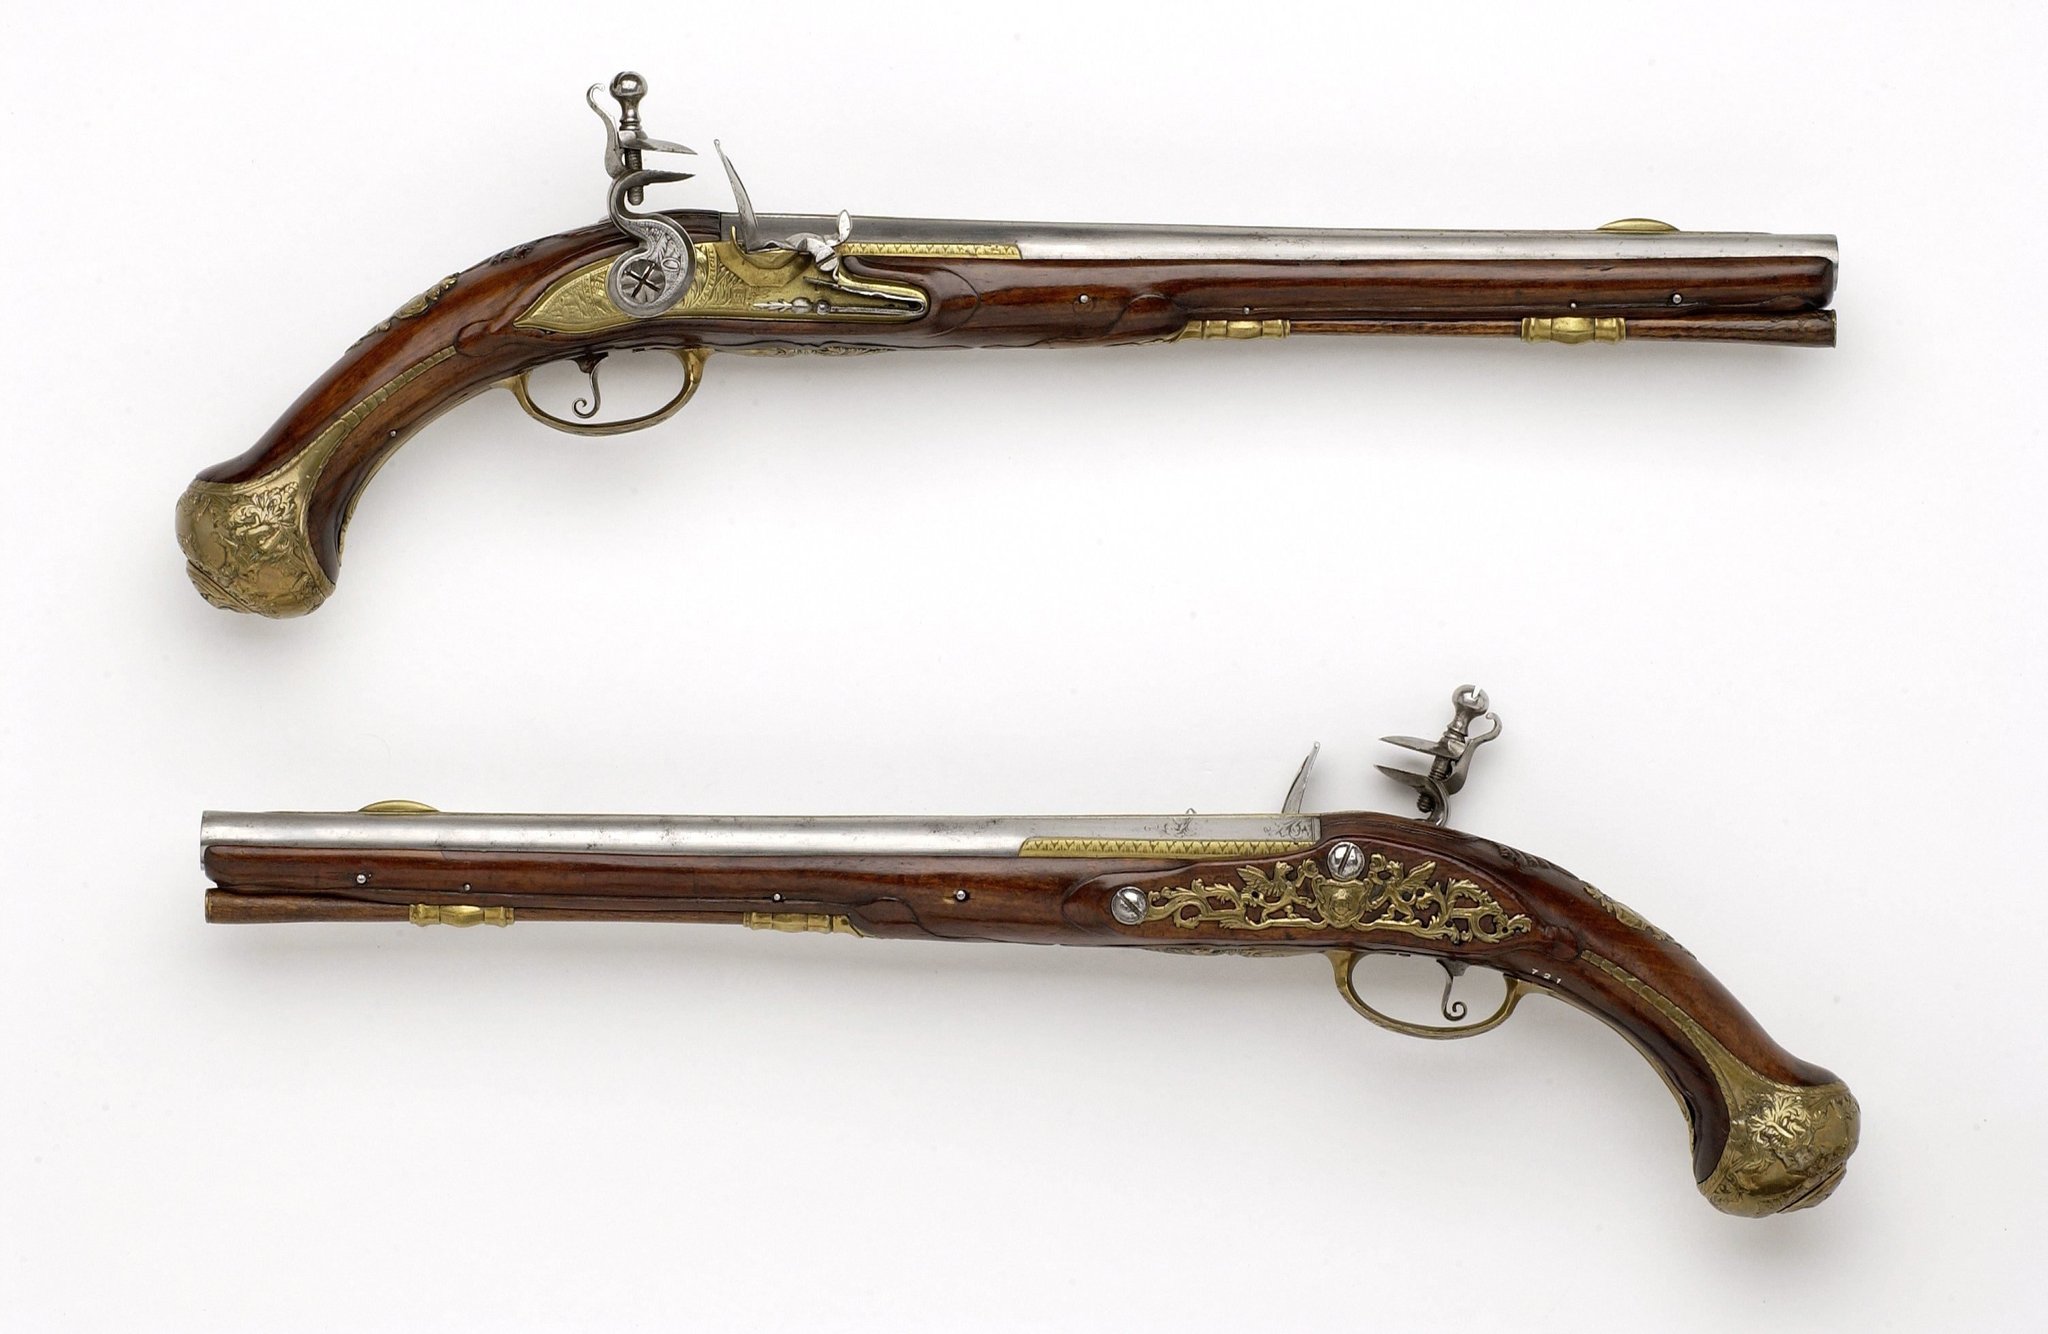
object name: flintlock pistol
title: Vuursteenpistool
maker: jan krans jr.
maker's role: geweermaker, pistoolmaker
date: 1705-1710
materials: brass, iron, wood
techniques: casting, metalworking, cutting, embroidery, engraving, relief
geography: maastricht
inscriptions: inscription: ‘JEAN KRANS AMASTRICHT’, inscription: ‘IEAN KRANS // AMASTRICHT’